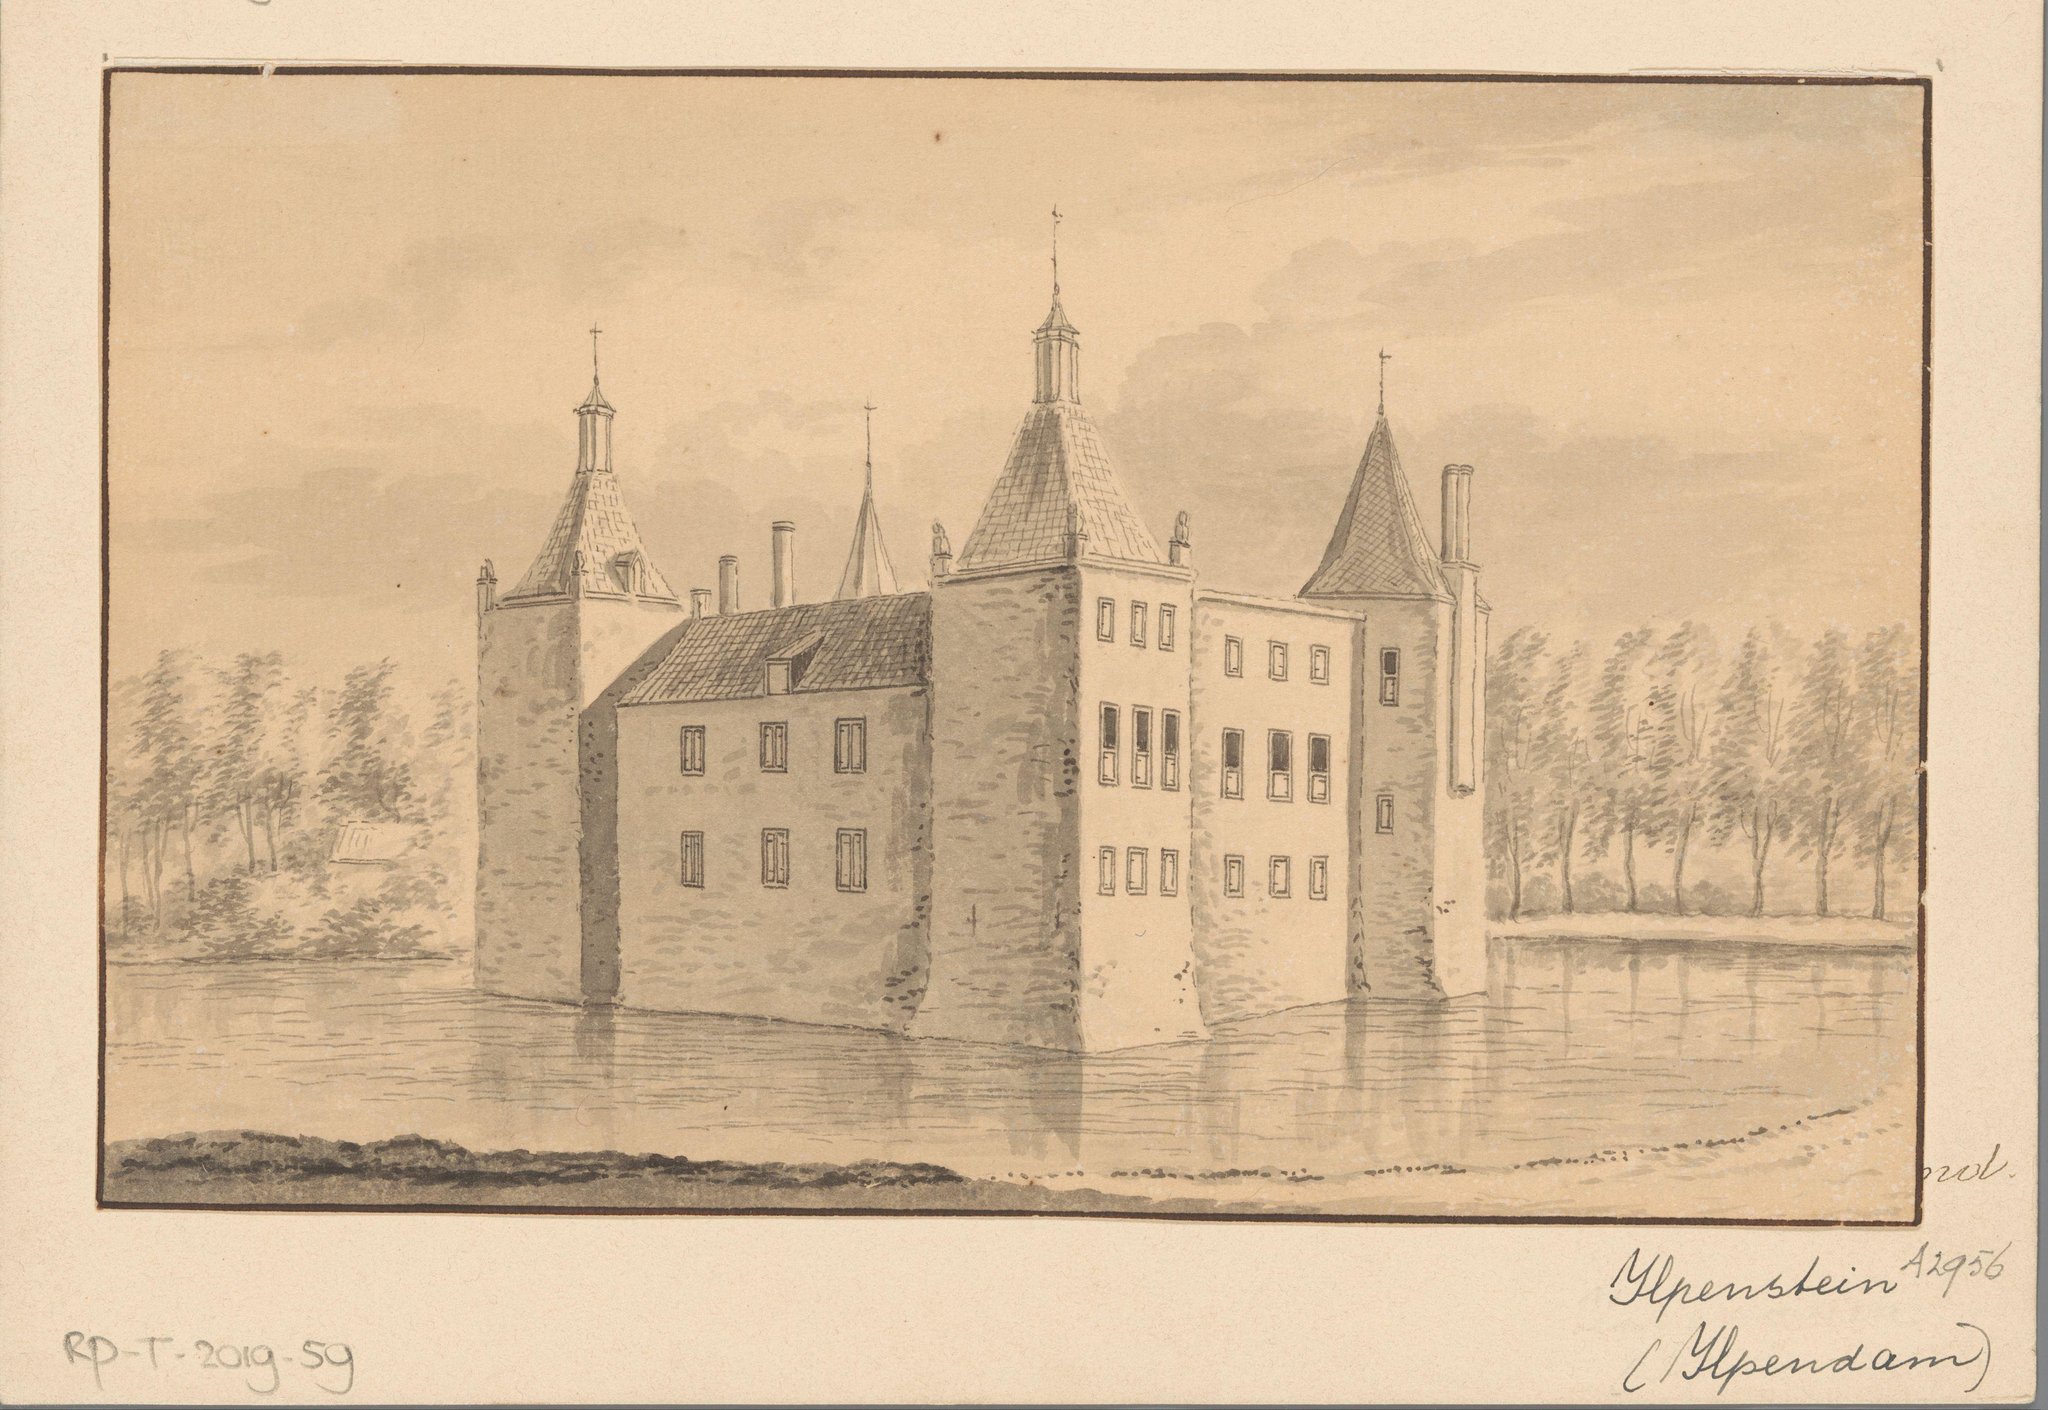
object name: drawing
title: Gezicht van de achterzijde van slot Ilpenstein in de Purmer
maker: Anonymous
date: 1700-1799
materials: ink, paper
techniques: brush, pen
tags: castle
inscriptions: collector's mark: Lugt 2228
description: Ook bekend als Huis (of Hof) te Ilpendam, het slot van de vrije en hoge heerlijkheid Purmerland en Ilpendam in Waterland.